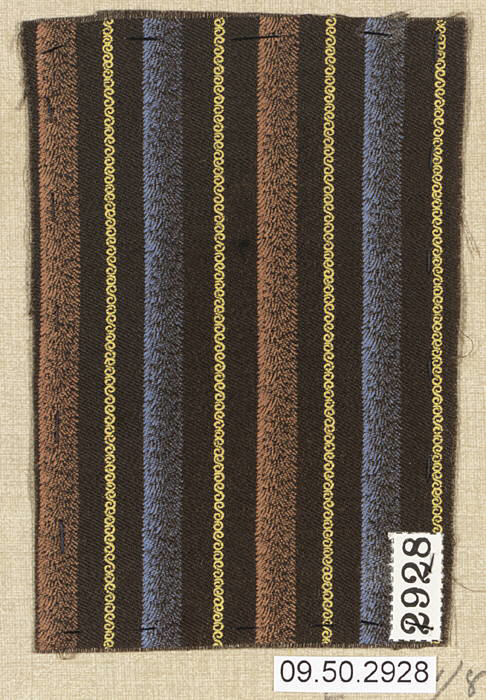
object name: piece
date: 1801-1900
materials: cotton